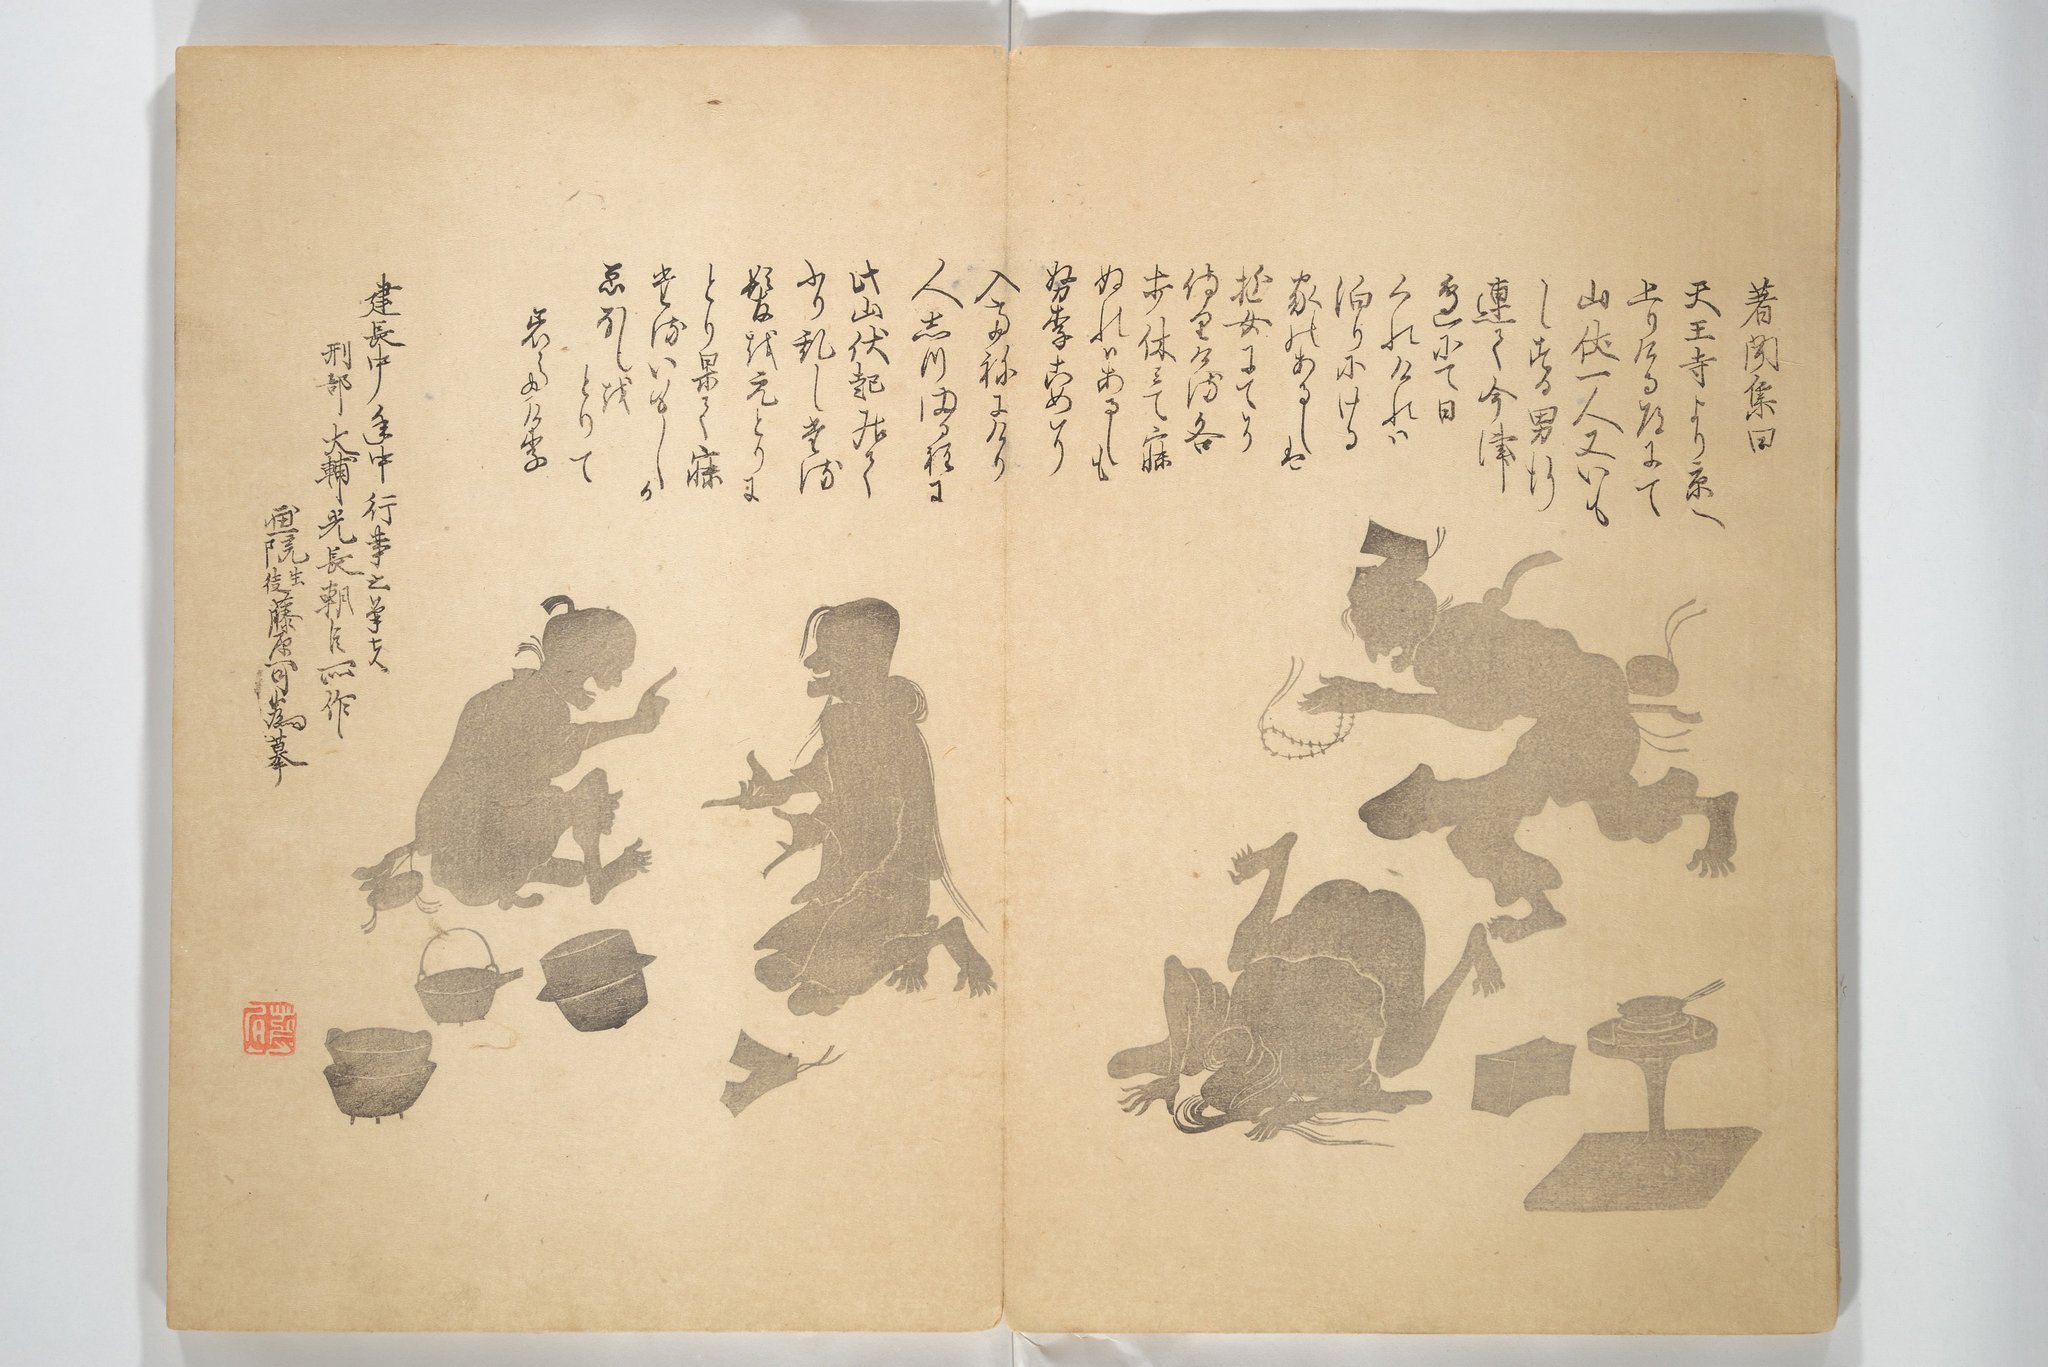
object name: illustrated book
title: Album of Flowers and the Moon (Kagetsu jō) 花月帖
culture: japanese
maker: mori tetsuzan 森徹山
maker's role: artist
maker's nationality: japanese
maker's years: 1775-1841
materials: ink, paper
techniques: woodblock print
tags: human figures